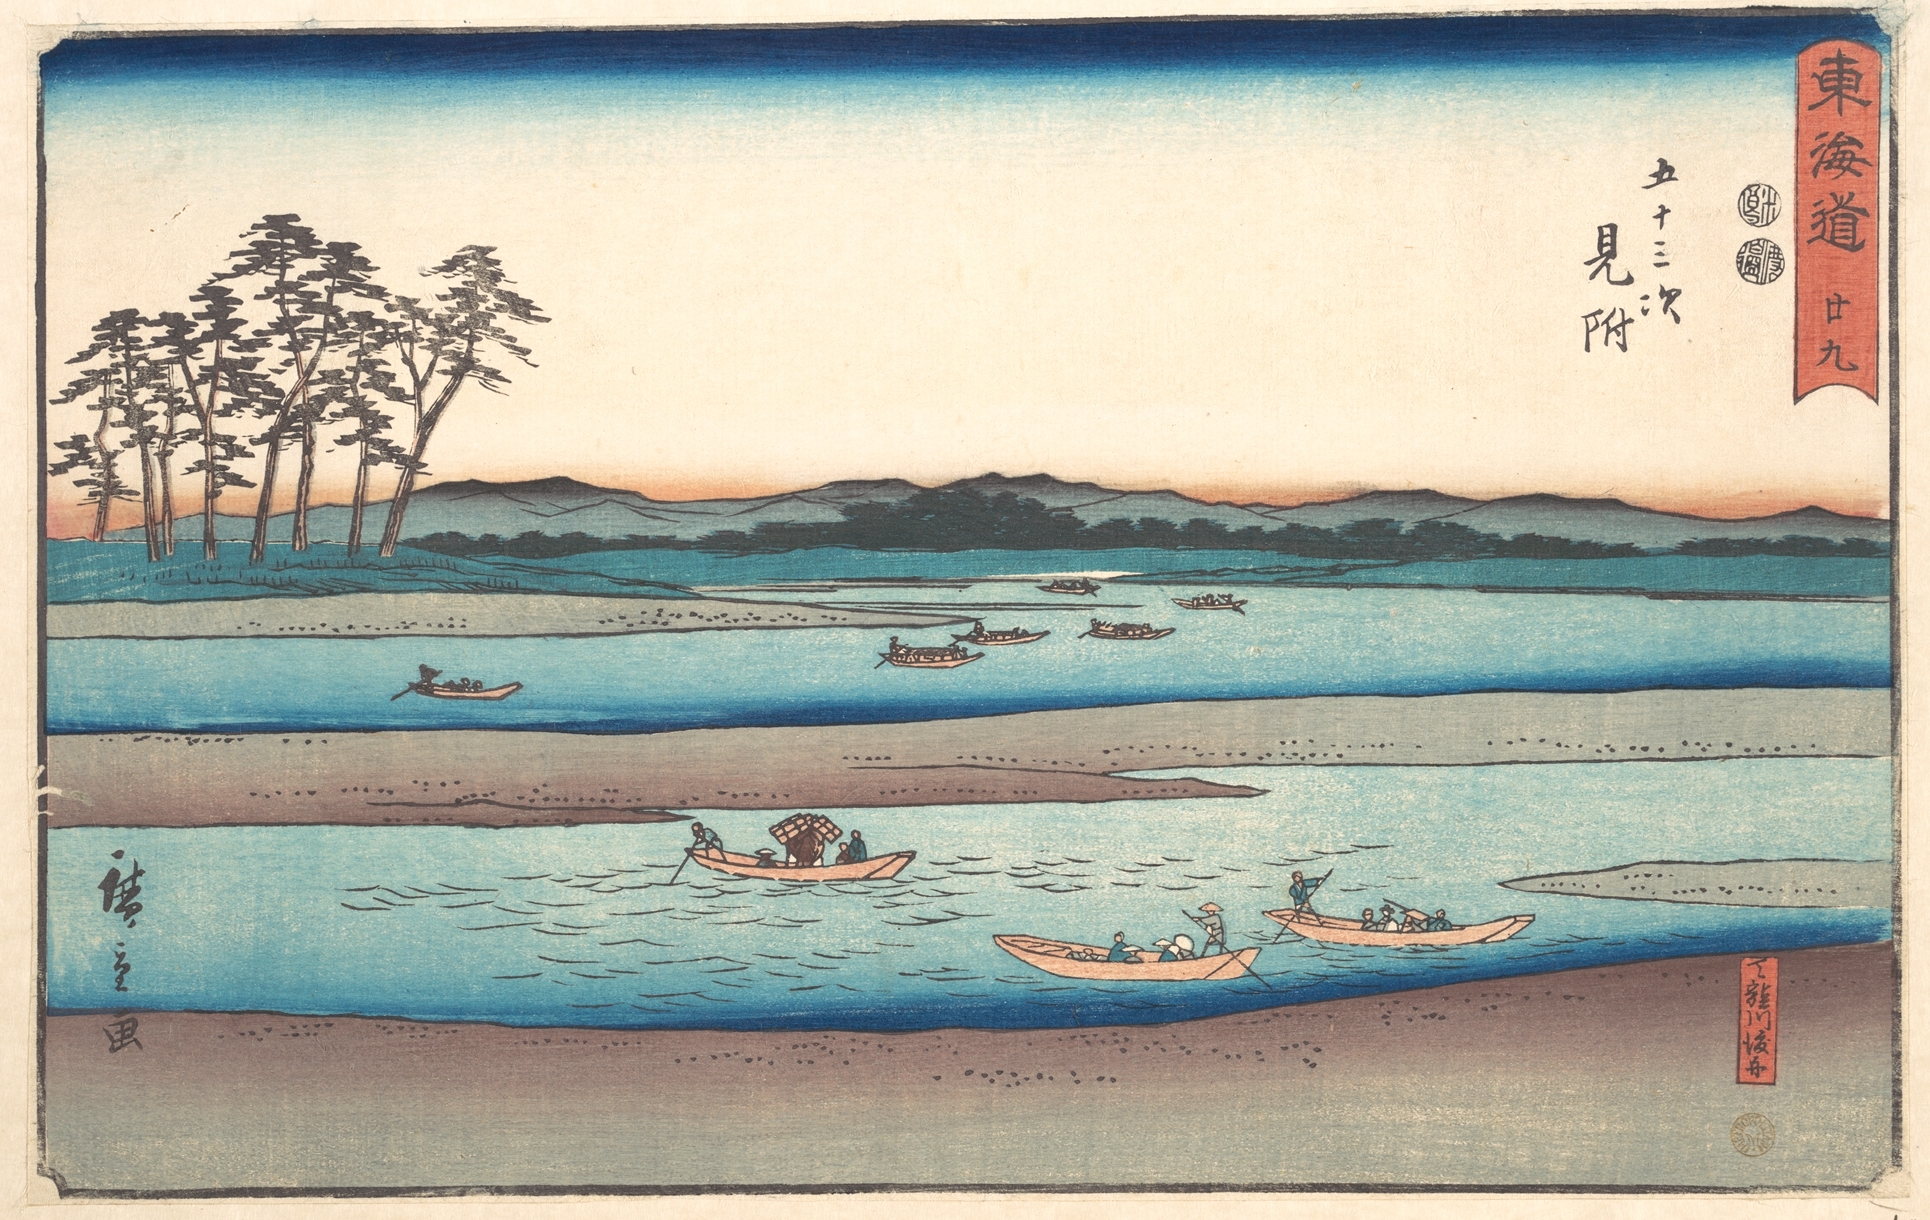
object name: print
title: Mitsuke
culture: japanese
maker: utagawa hiroshige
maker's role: artist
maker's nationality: japanese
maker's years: 1797-1858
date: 1840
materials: ink, paper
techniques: woodblock print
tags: rivers,landscapes,boats